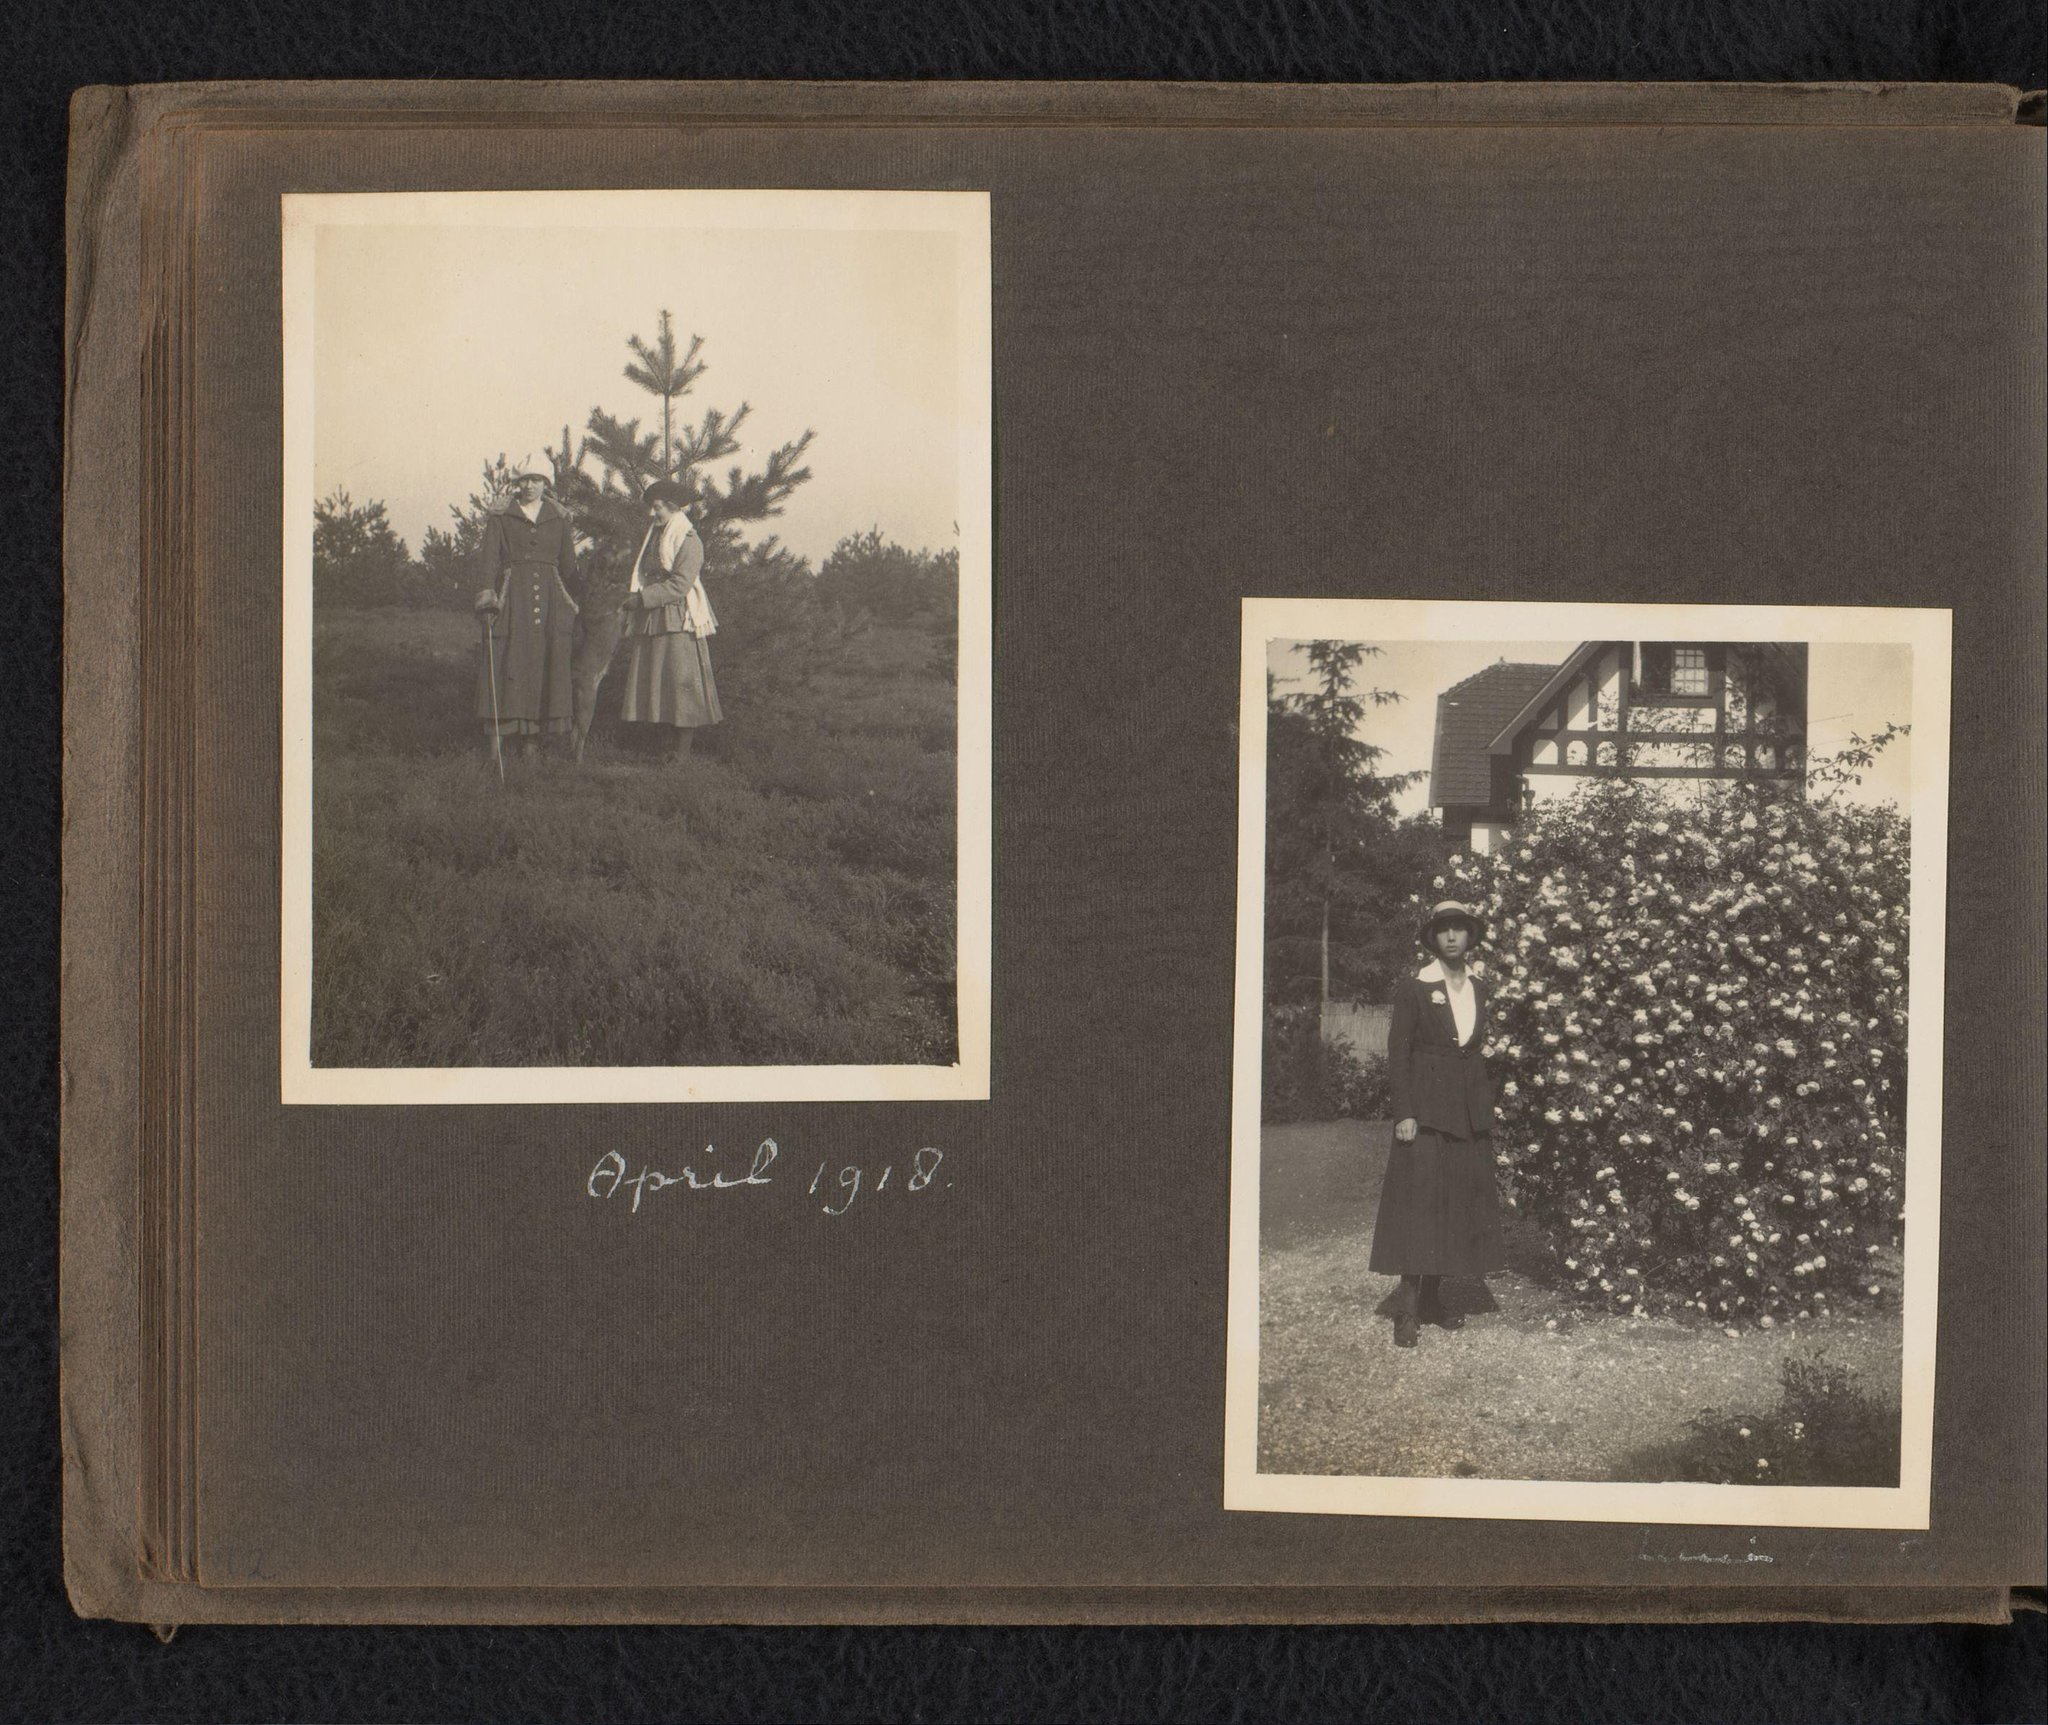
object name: album leaf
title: Twee foto's van twee vrouwen op de hei en een vrouw in de tuin van de Kroonlaan 1 in Hilversum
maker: Anonymous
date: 1904-1918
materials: paper, cardboard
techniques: gelatin silver print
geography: hilversum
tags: historical persons - bb - woman, garden, meadow, pasture, shrubs: rose-bush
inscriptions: caption: ‘April 1918.’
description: Deze foto's maken deel uit van een album.